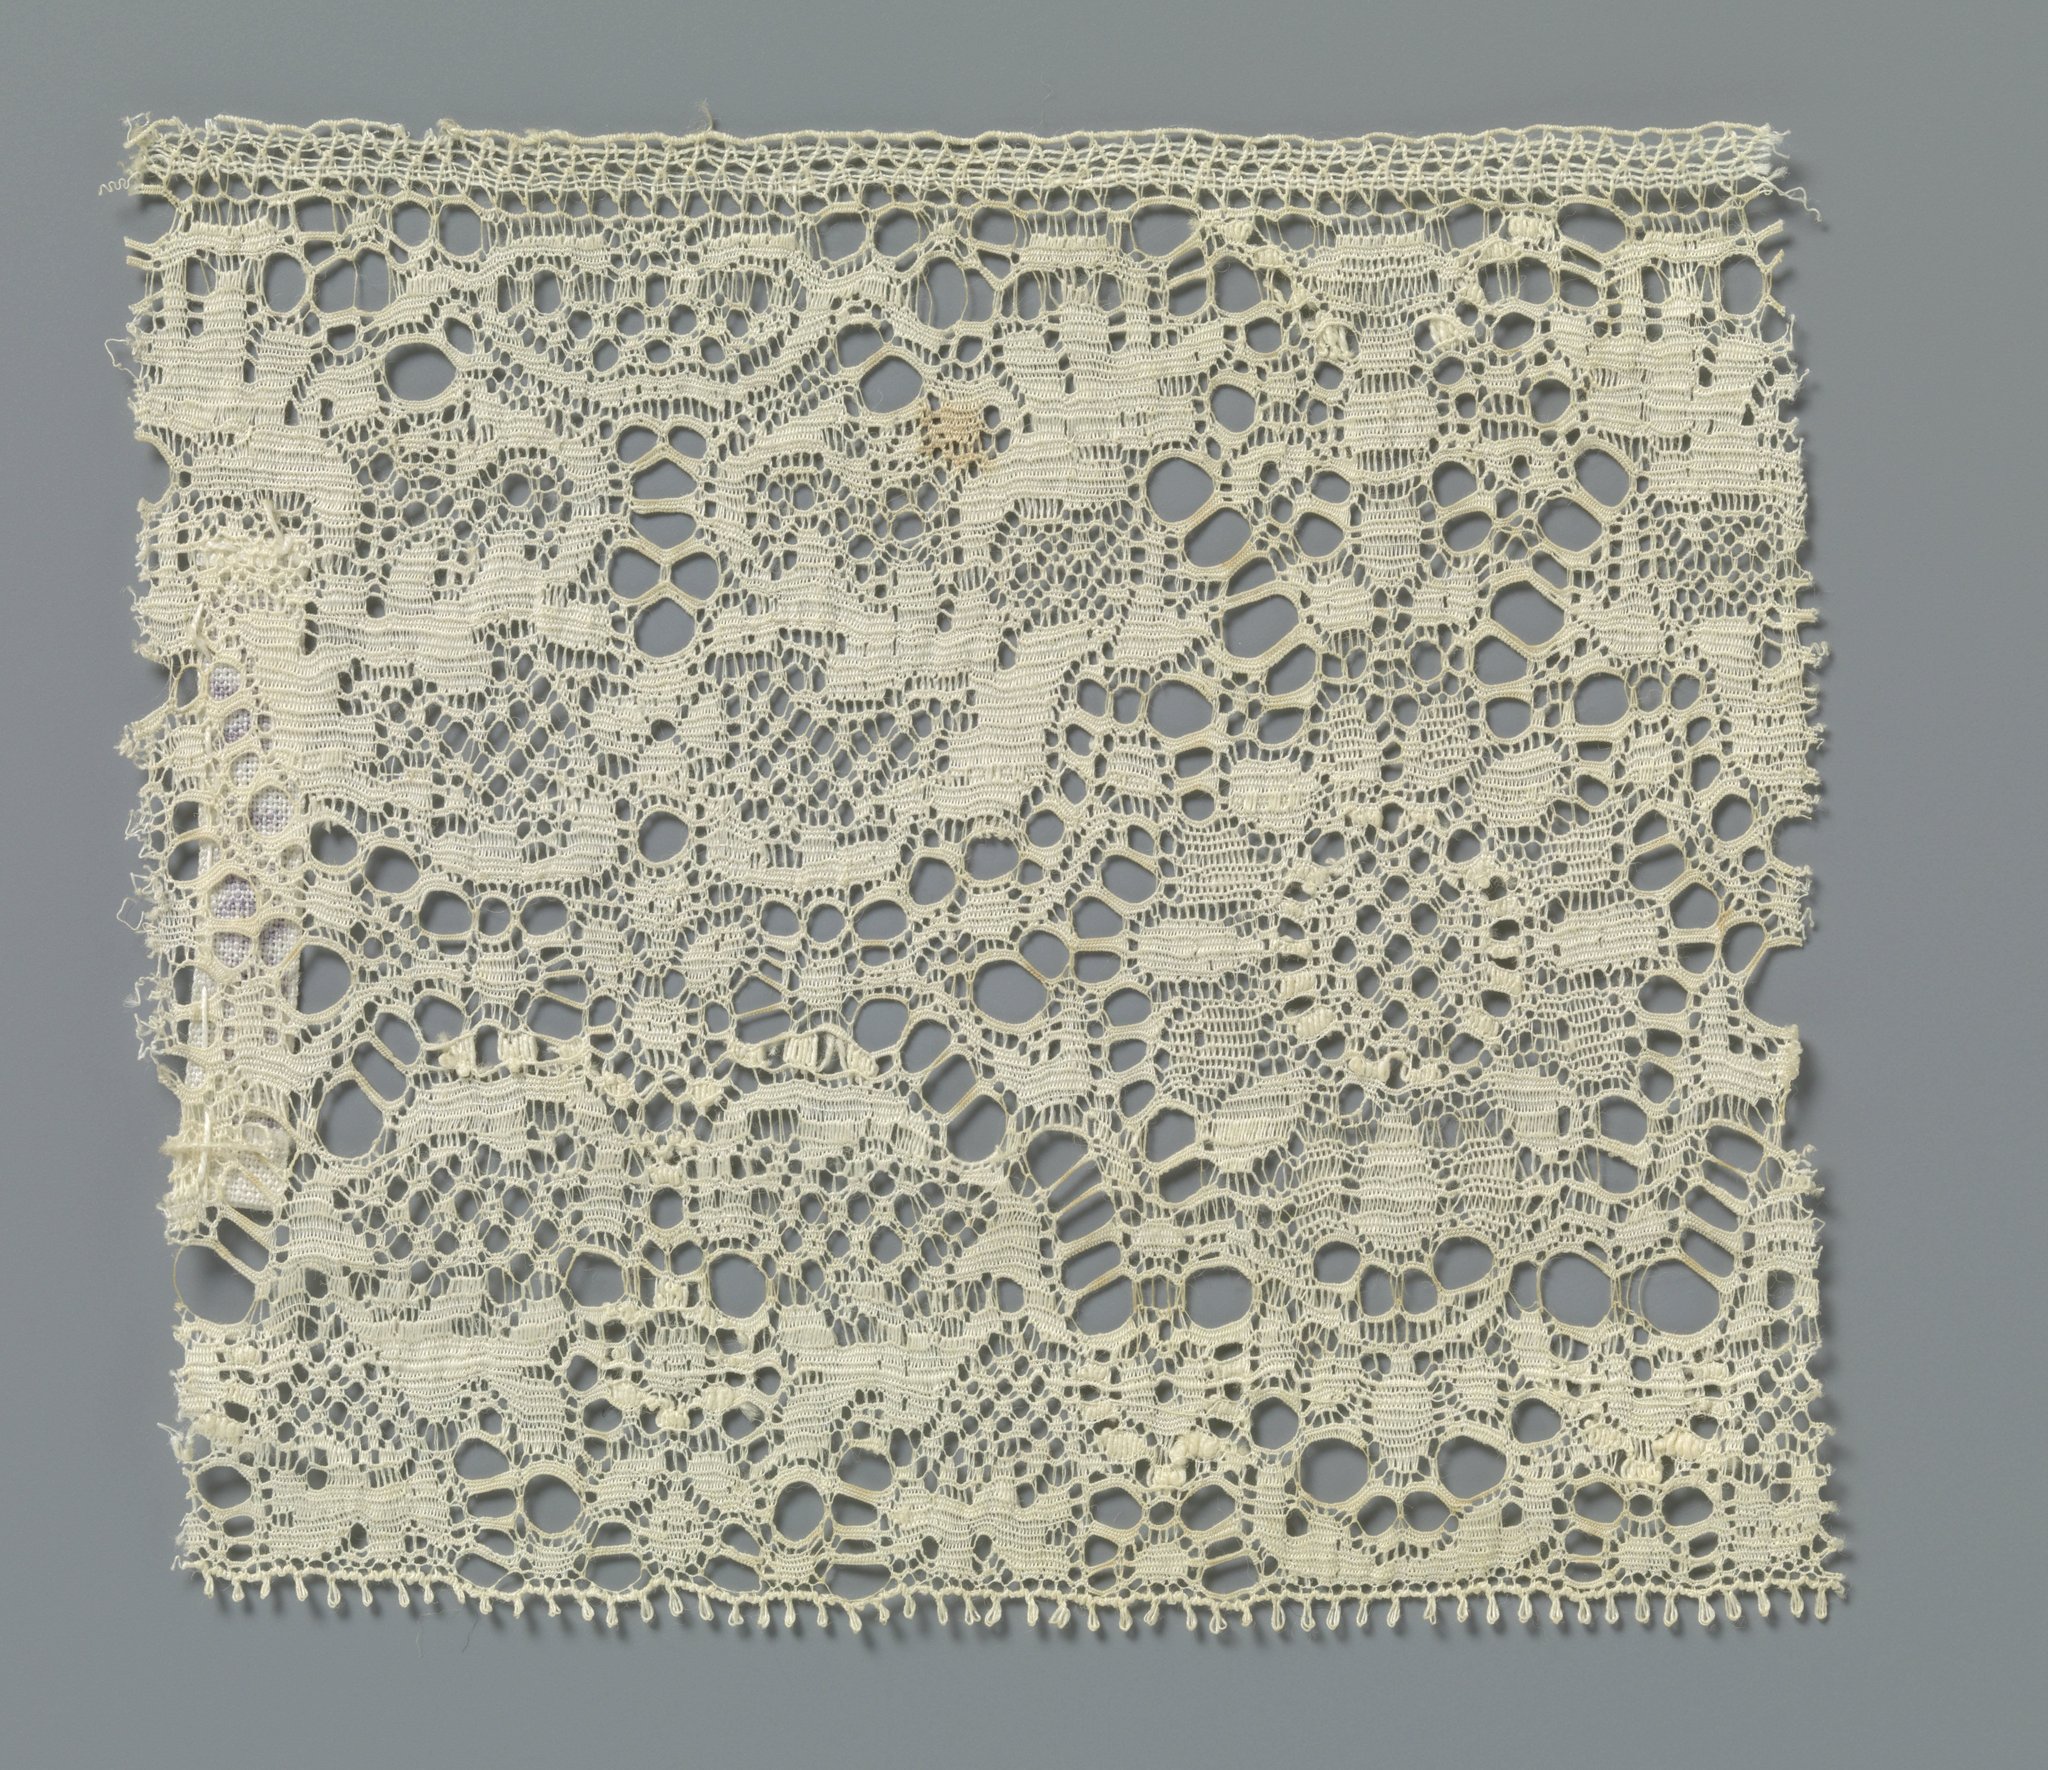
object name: strip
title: Strook machinale kant met zonnebloem en kandelaber-motief met gevederde bladkrullen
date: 1881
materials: cotton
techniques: lace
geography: calais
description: Strook machinale kant: machinale Binche-kant. Het symmetrische patroon wordt gevormd door een hangende zonnebloem of margriet naast een kandelaber-achtig motief dat is opgebouwd uit omkrullende gevederde bladeren, met een kroon in de top. De motieven zijn voorzien van opengewerkte randjes en zijn met elkaar verbonden door een machinale vlechtengrond. Als siergrond zijn verschillende machinale sneeuwvlokkengronden toegepast. Boven- en onderzijde van de strook zijn recht afgewerkt, waarbij de onderzijde is voorzien van picots.